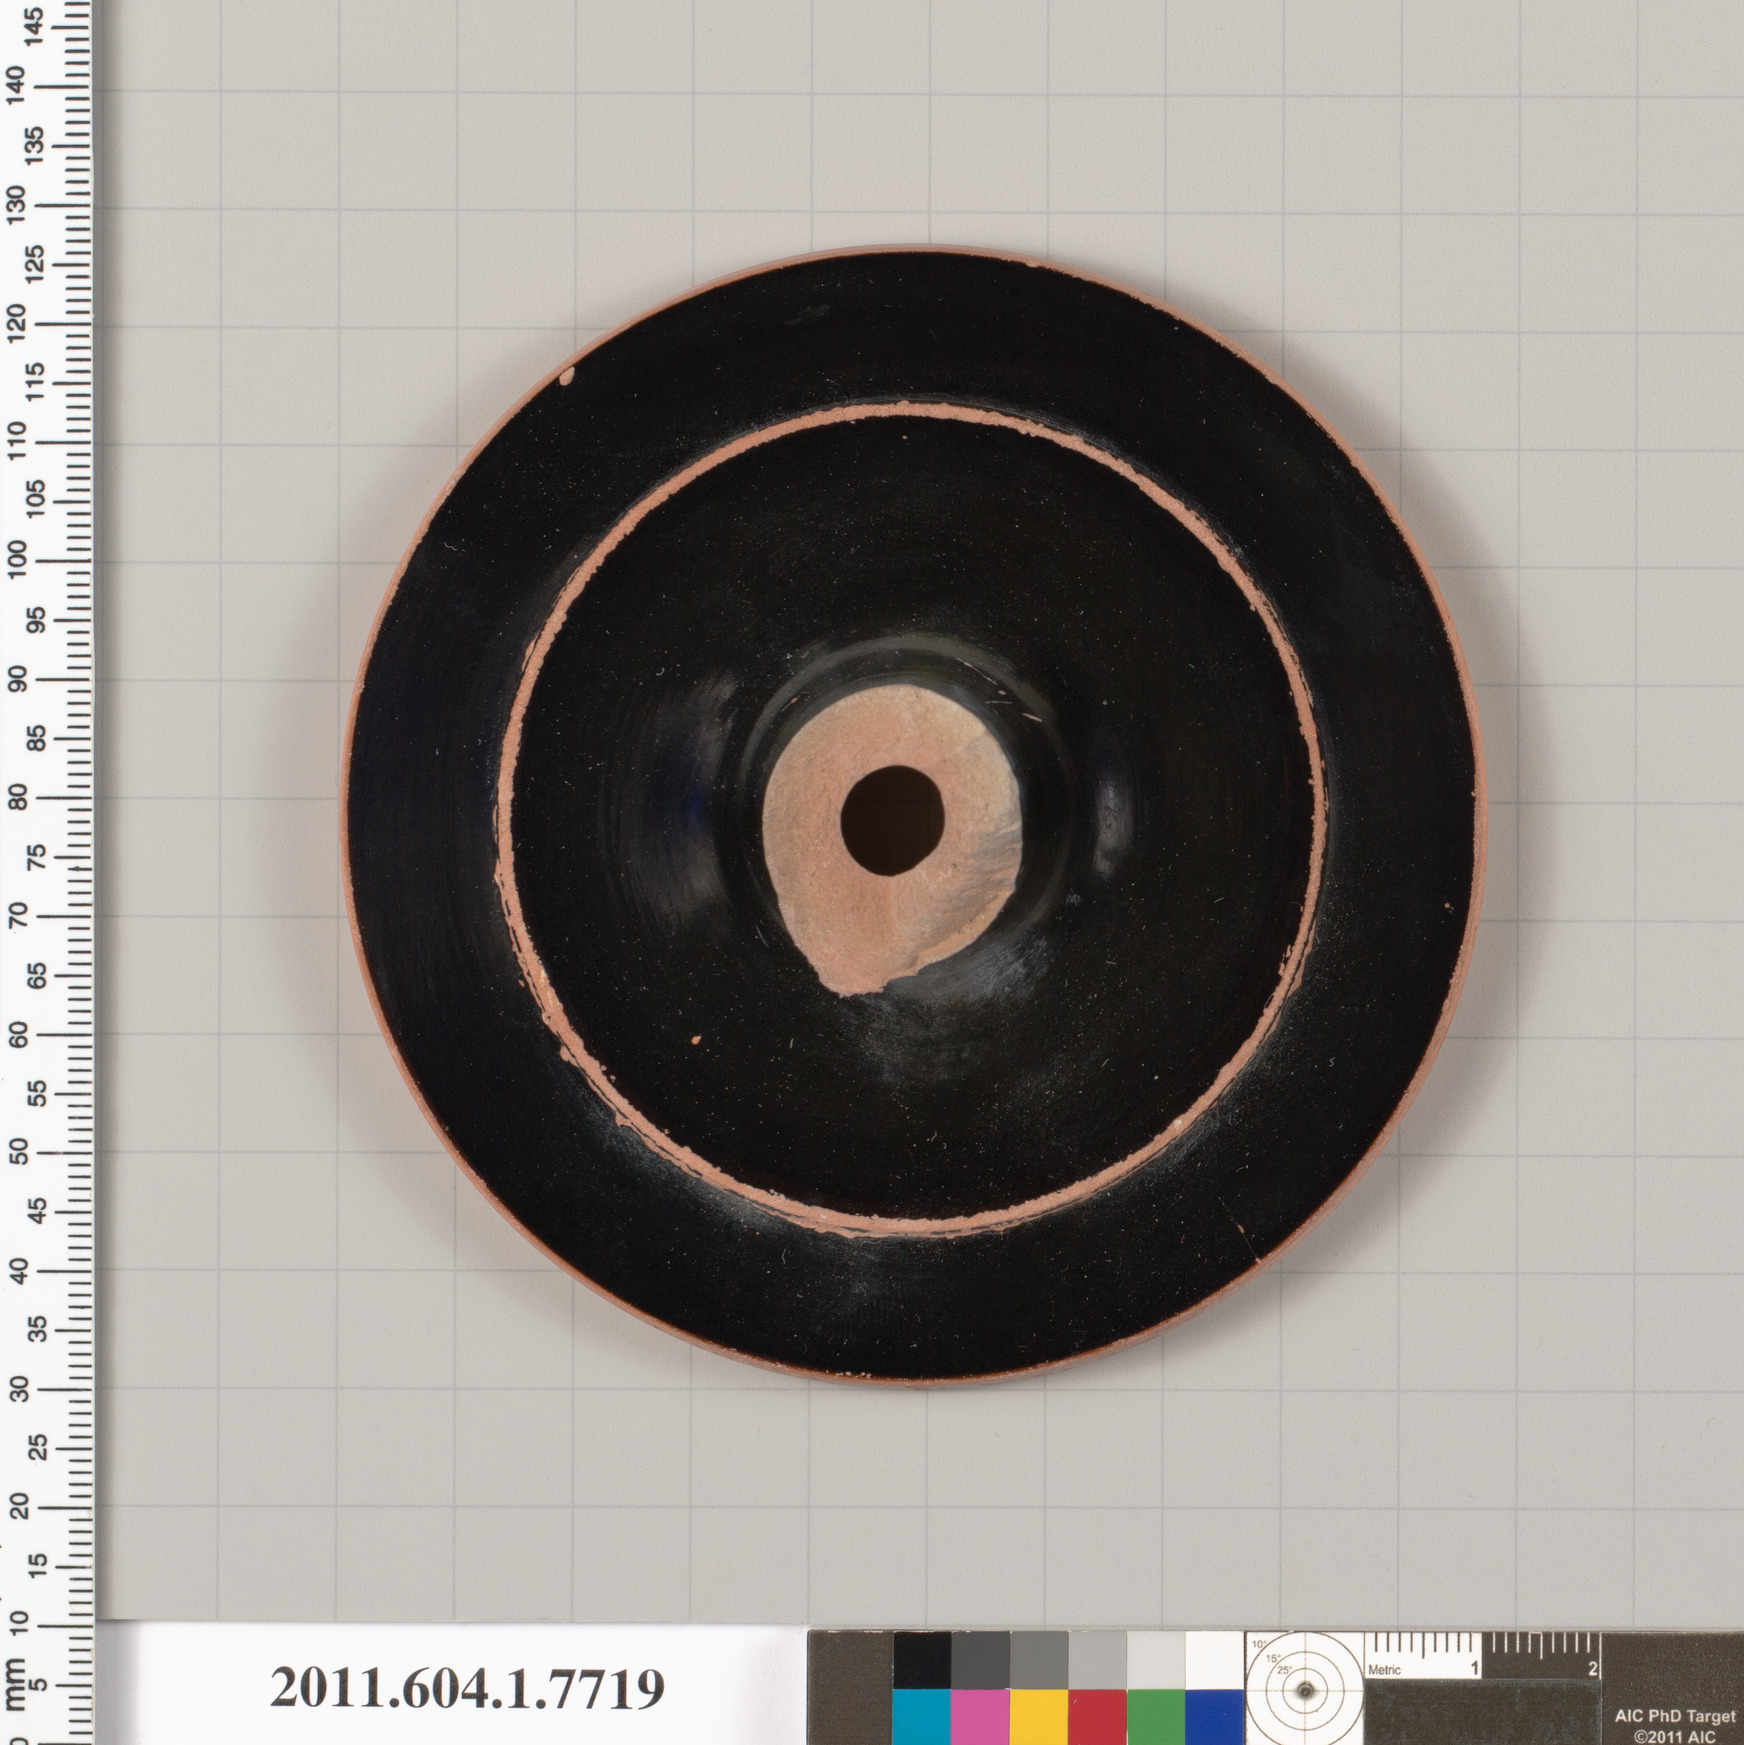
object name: kylix fragment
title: Terracotta fragment of a kylix (drinking cup)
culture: greek, attic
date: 475-451 BCE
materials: terracotta